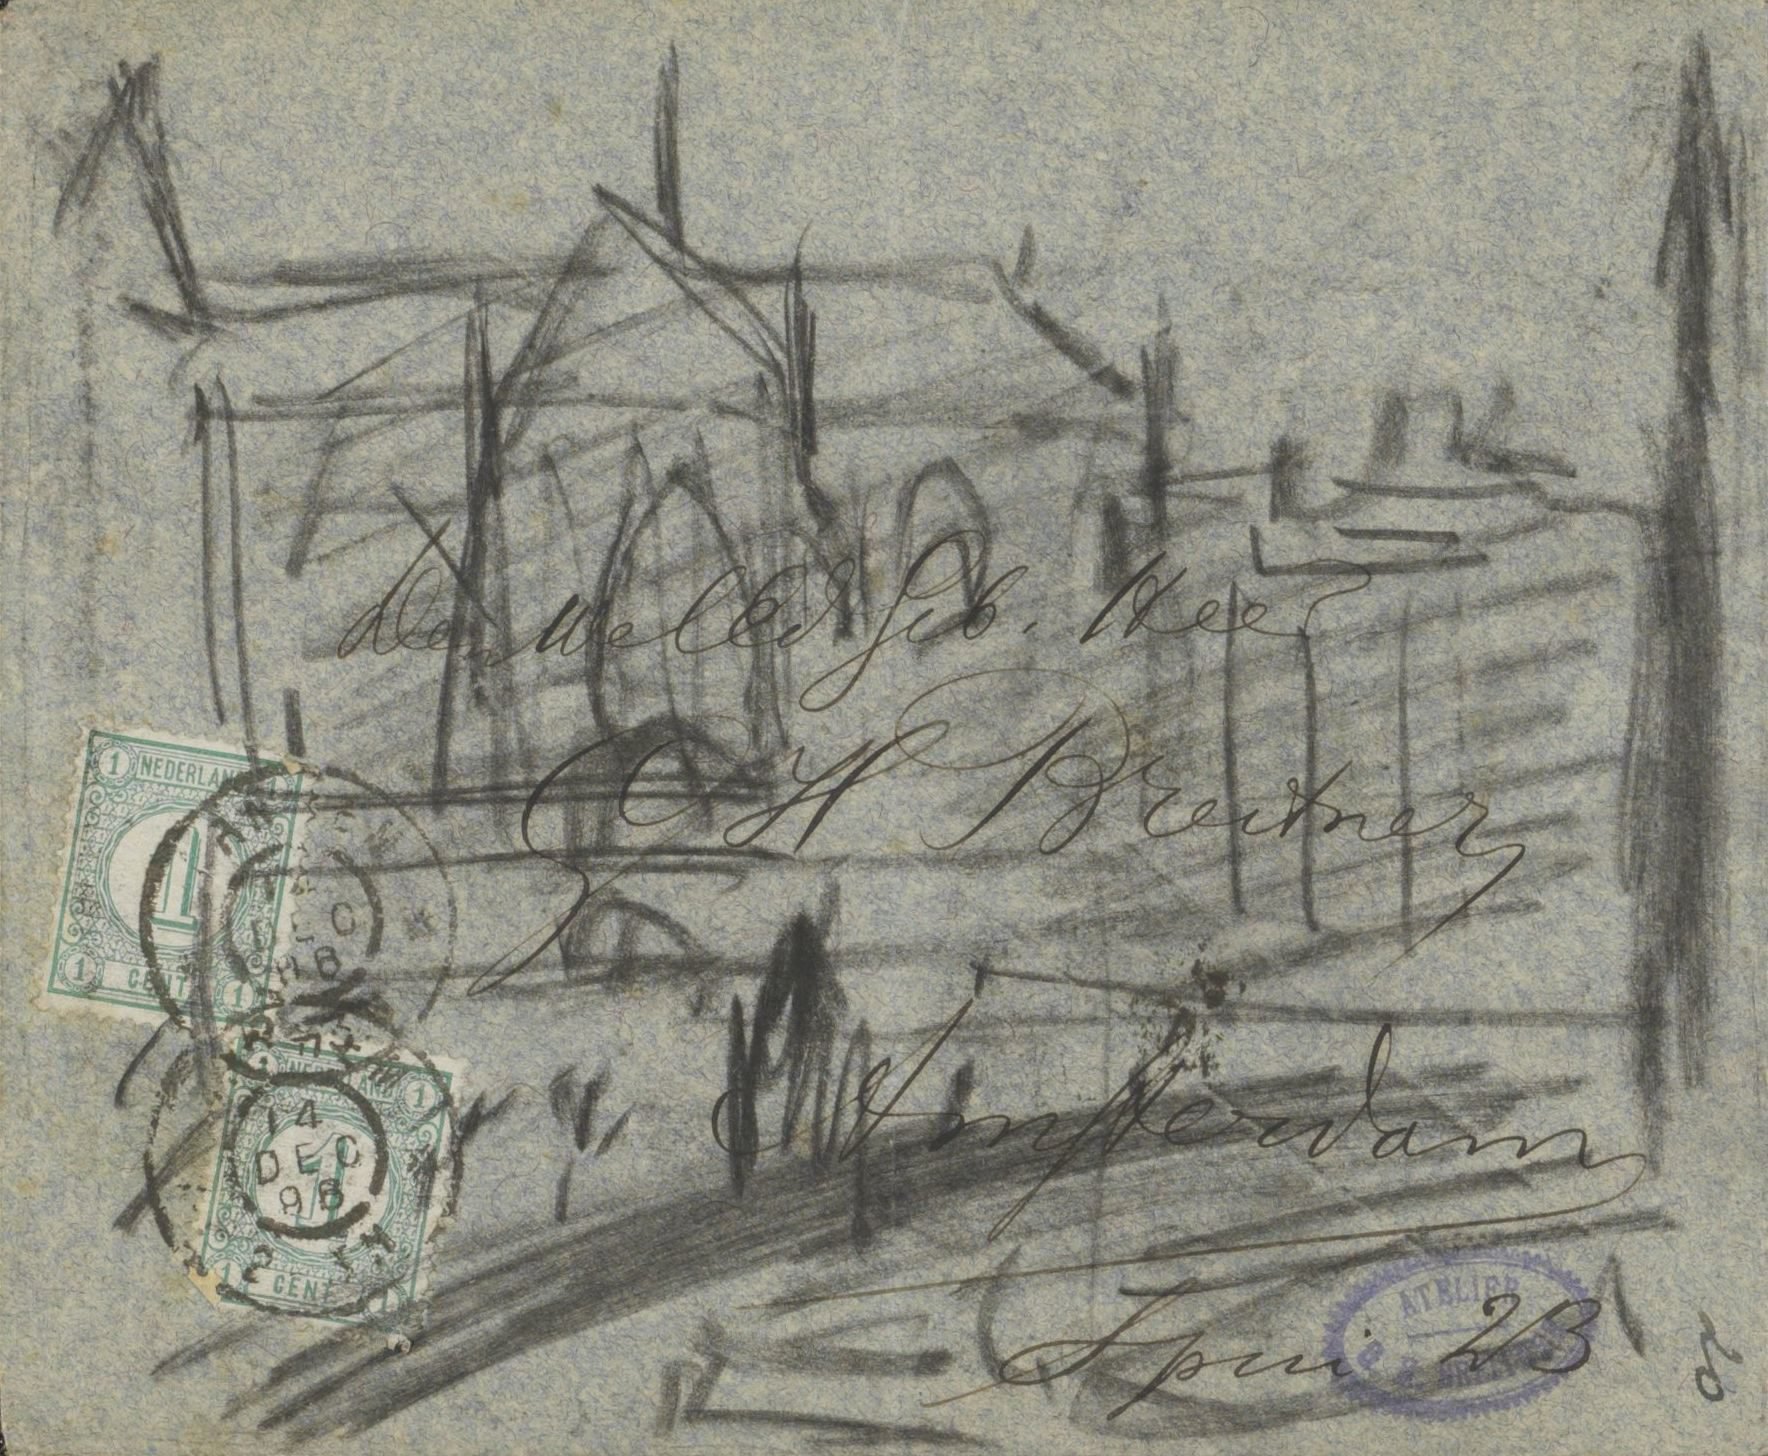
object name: envelope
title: Gezicht op de Dam te Amsterdam met de Nieuwe Kerk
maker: george hendrik breitner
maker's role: draughtsman, painter, print maker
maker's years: 1857-1923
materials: chalk, paper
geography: amsterdam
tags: church (exterior), square, place, circus, etc. (+ city(-scape) with figures, staffage)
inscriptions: workshop stamp: Lugt 291d, collector's mark: Lugt 2228, stamp: ‘[...] 14/ dec/ 98’, address: ‘de weledel geb. Heer/ GH Breitner/ Amsterdam/ Spui 23’